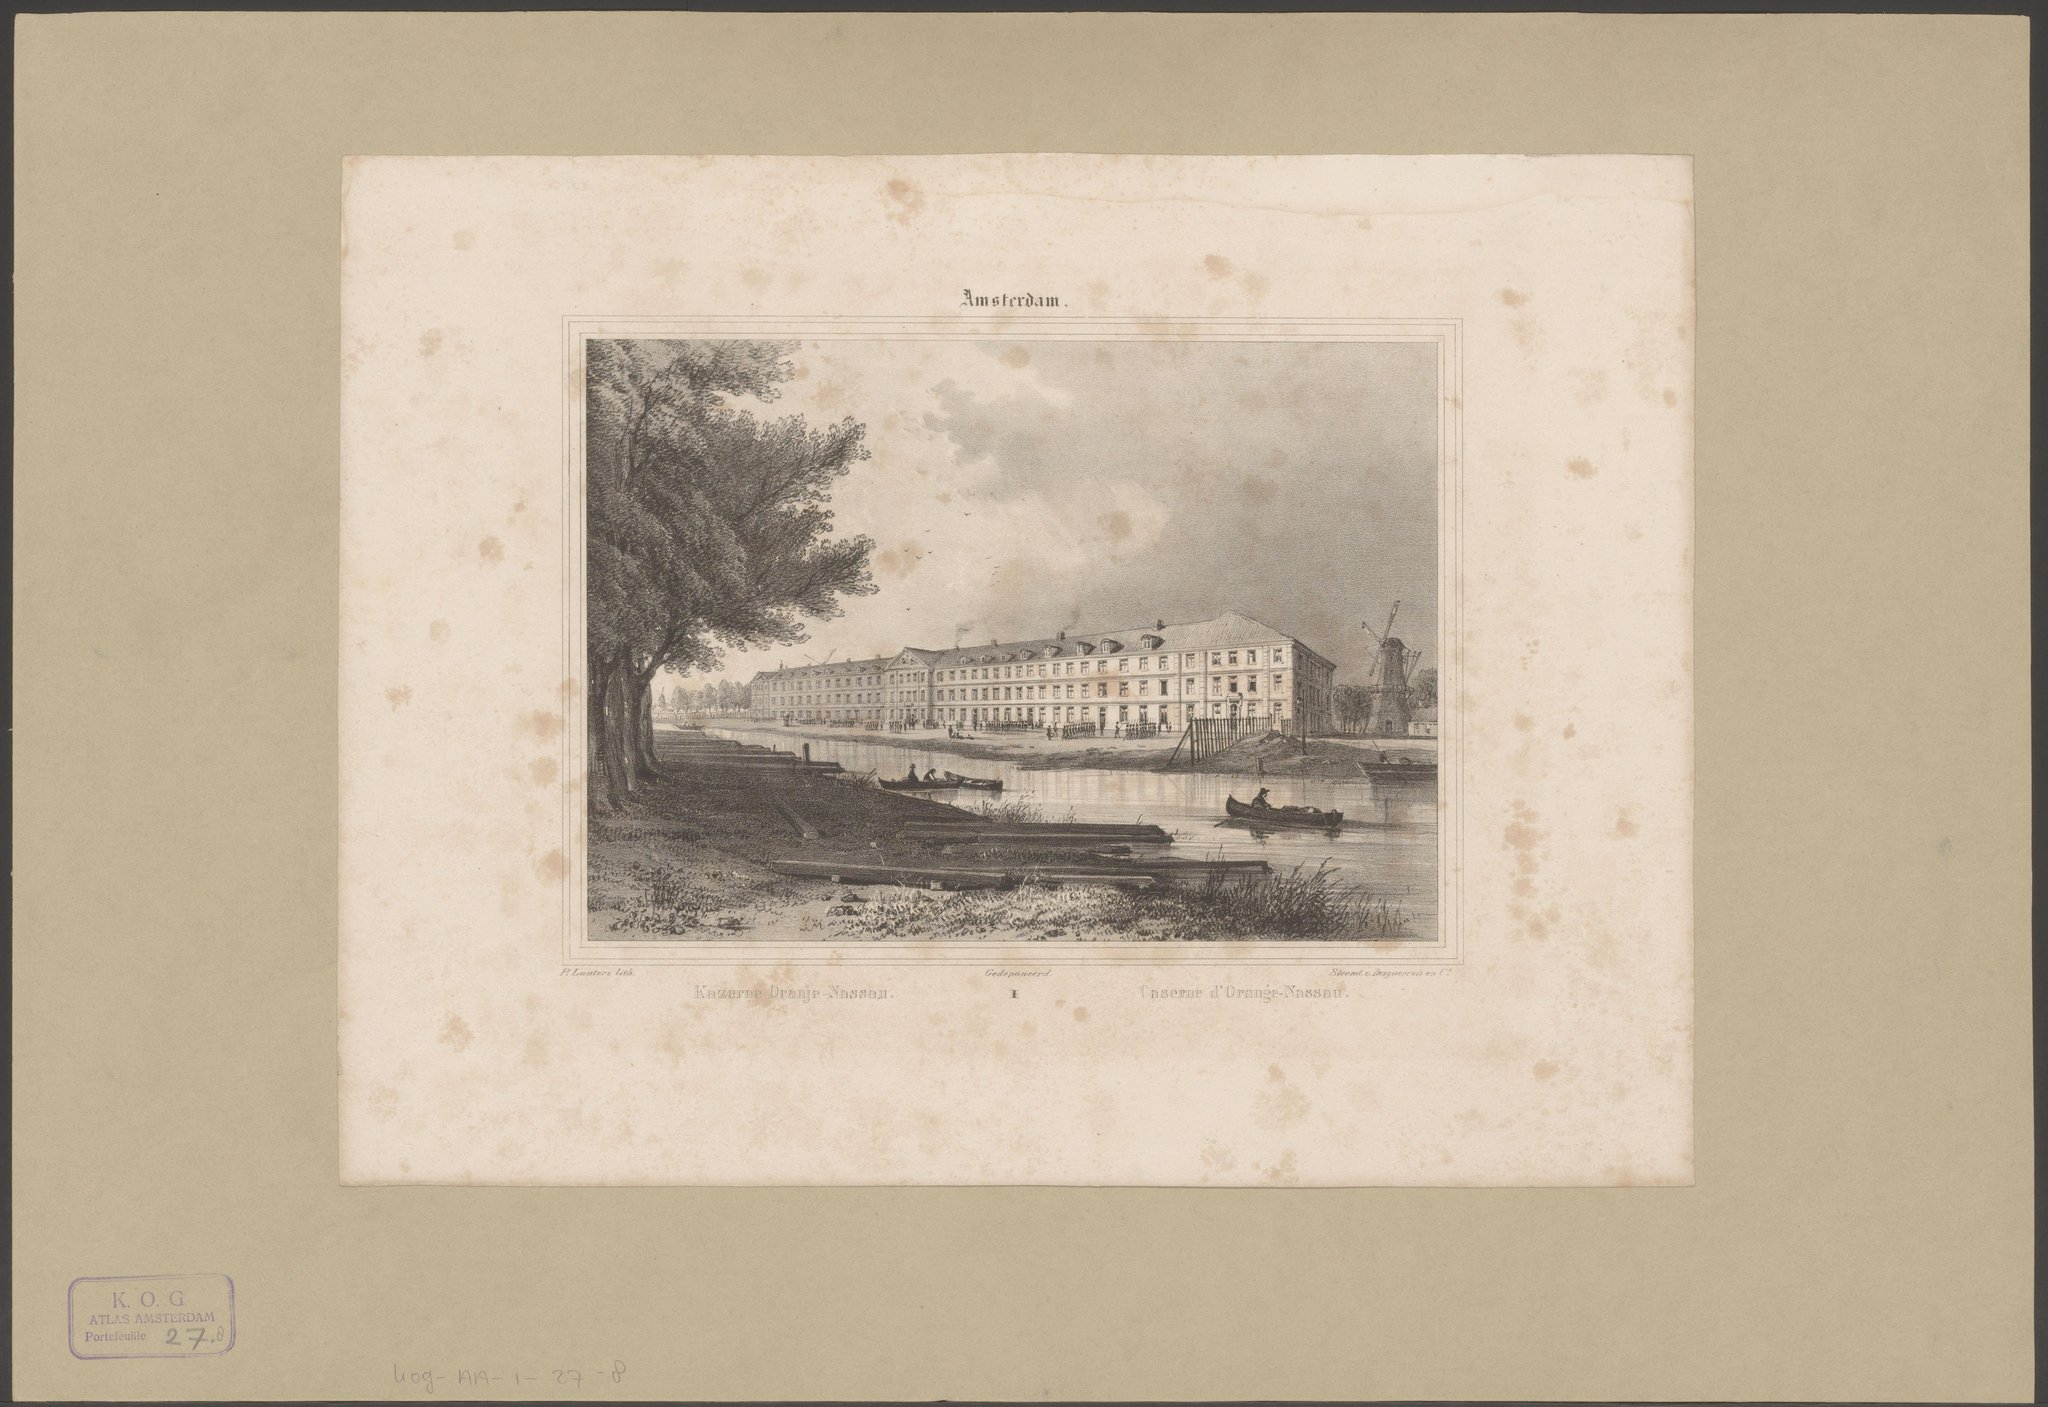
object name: print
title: Kazerne Oranje-Nassau / Caserne d'Orange-Nassau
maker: paulus lauters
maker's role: print maker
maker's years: 1806-1875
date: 1836-1840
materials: paper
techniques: lithograph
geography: brussels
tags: canals, waters (in city), barracks, windmill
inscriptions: collector's mark: Lugt 1641b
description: Prent maakt onderdeel uit van de serie: Hoofdgebouwen en gezichten der Voornaamste Steden van Holland. Onder deze naam werden in ieder geval verschillende stadgezichten gepubliceerd in de jaren 1836, 1839 en 1840 door Desguerrois & Co.